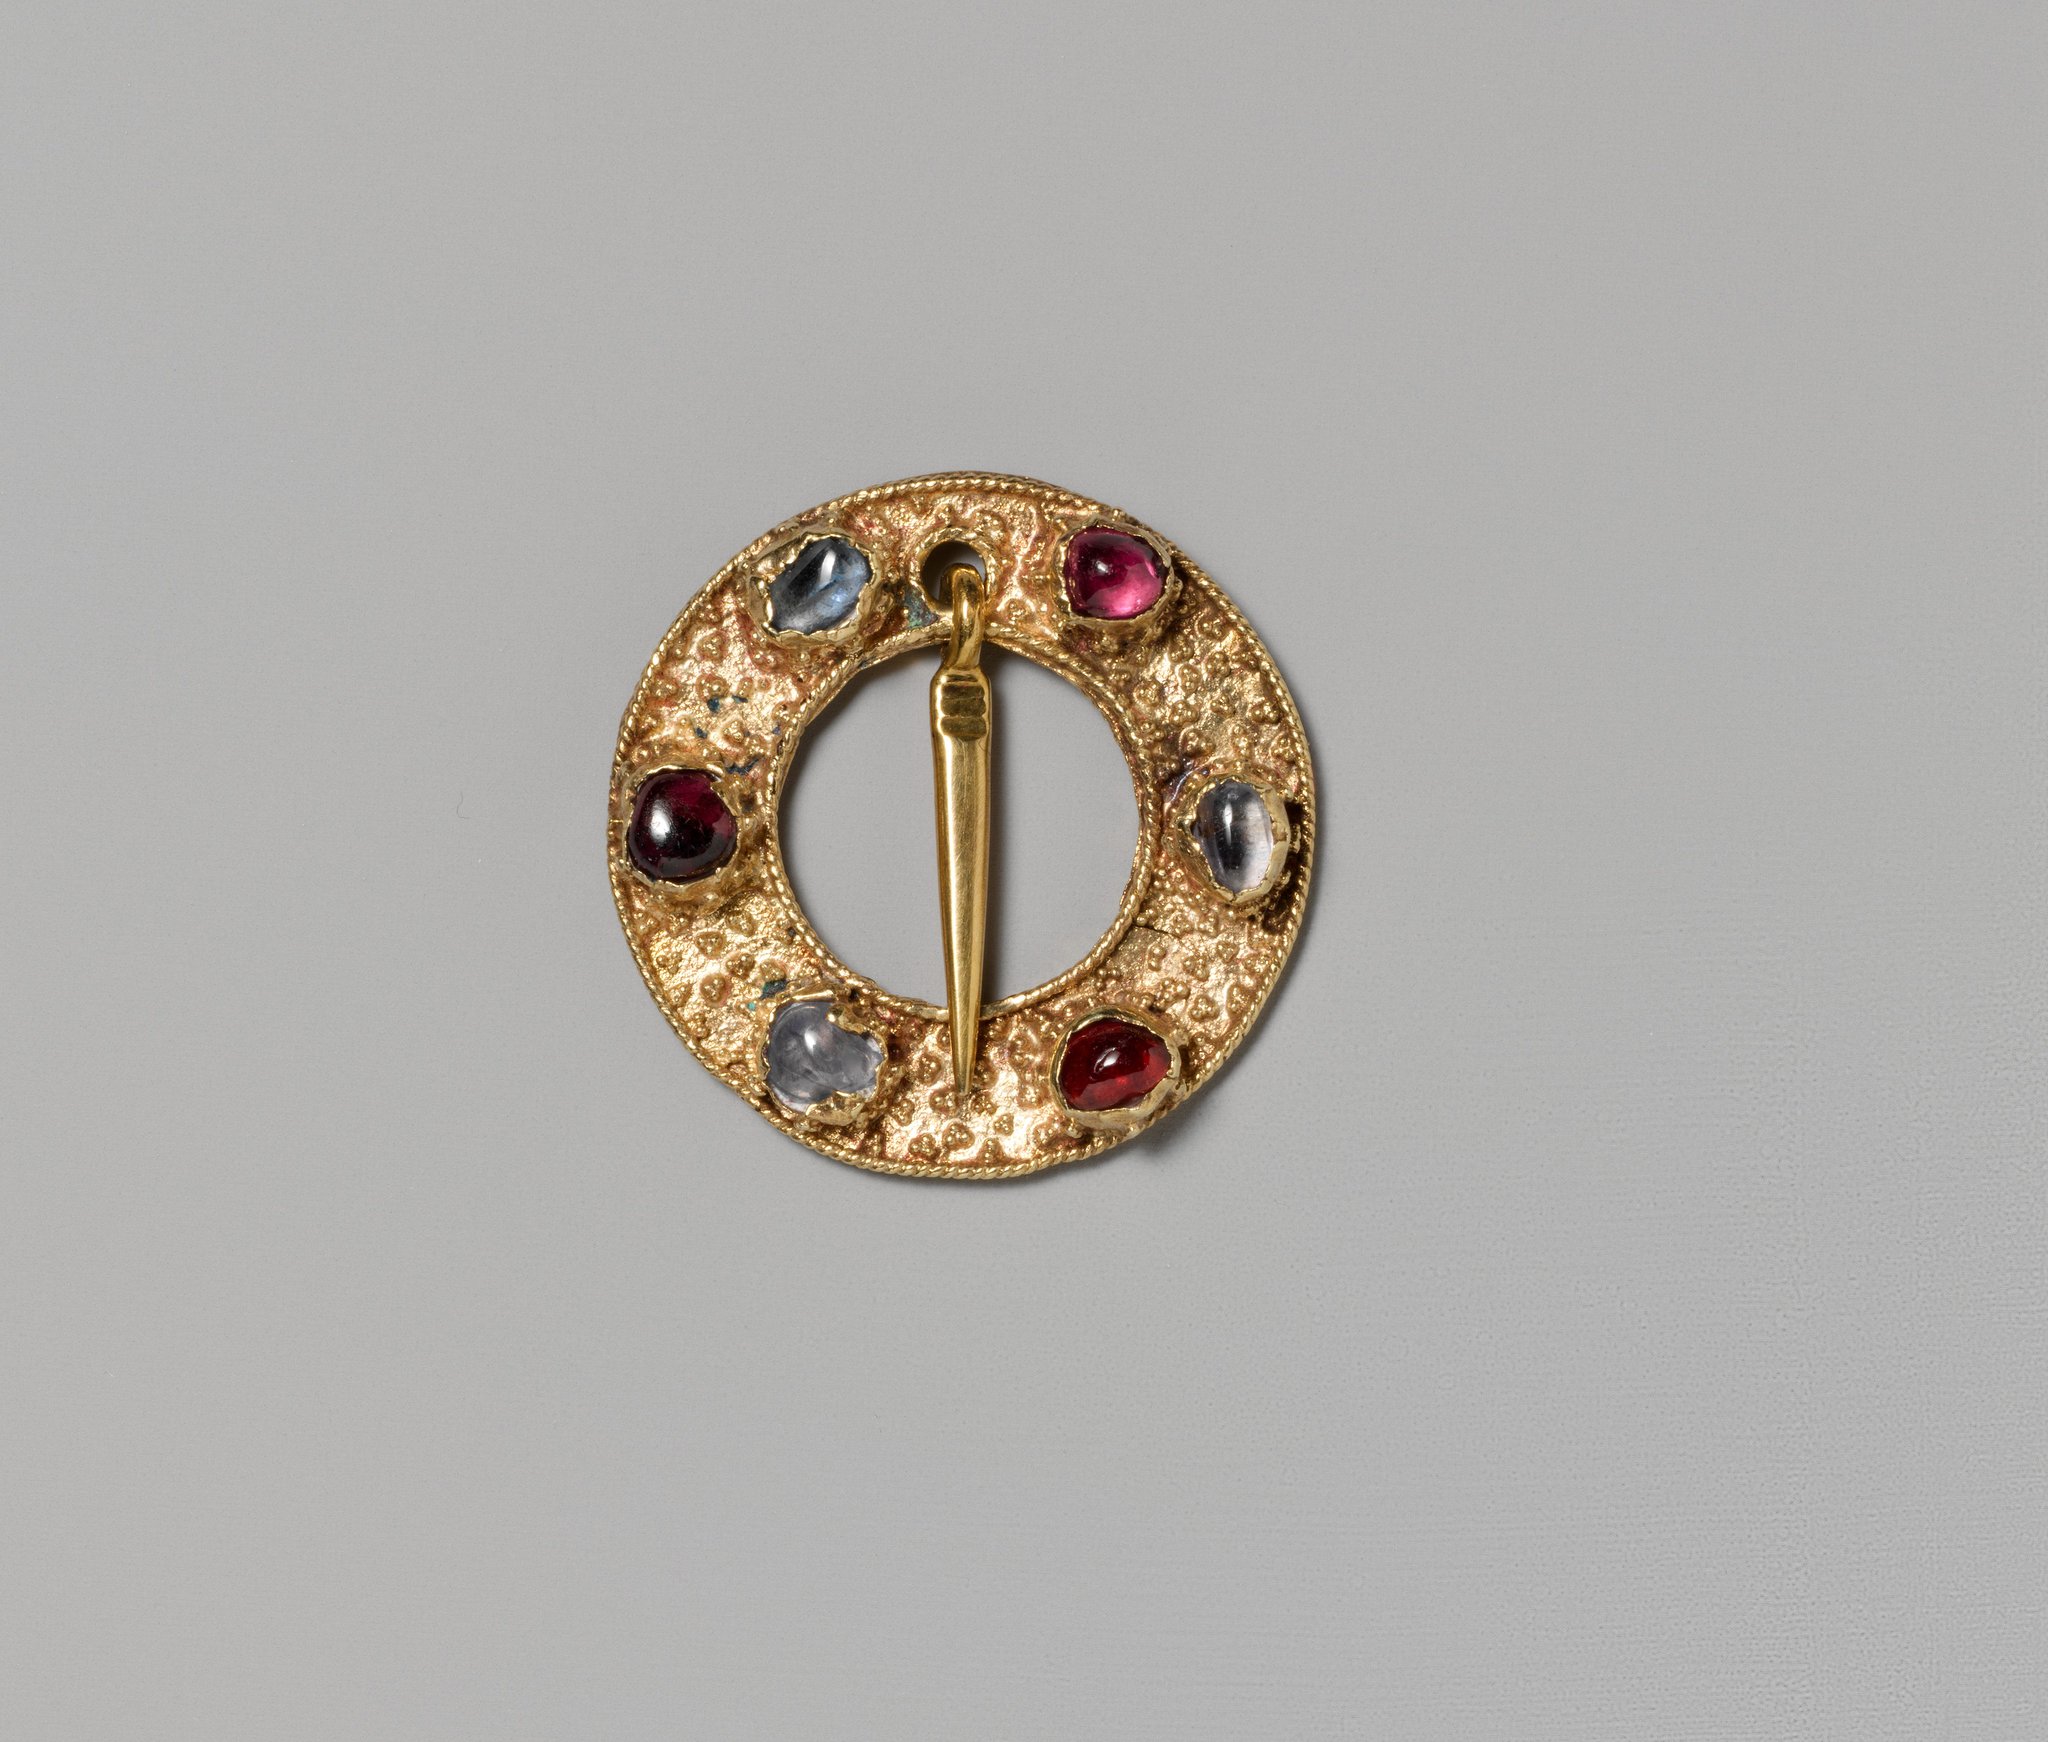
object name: brooch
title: Ring Brooch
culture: german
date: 1340-1349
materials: gold, gemstone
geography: germany